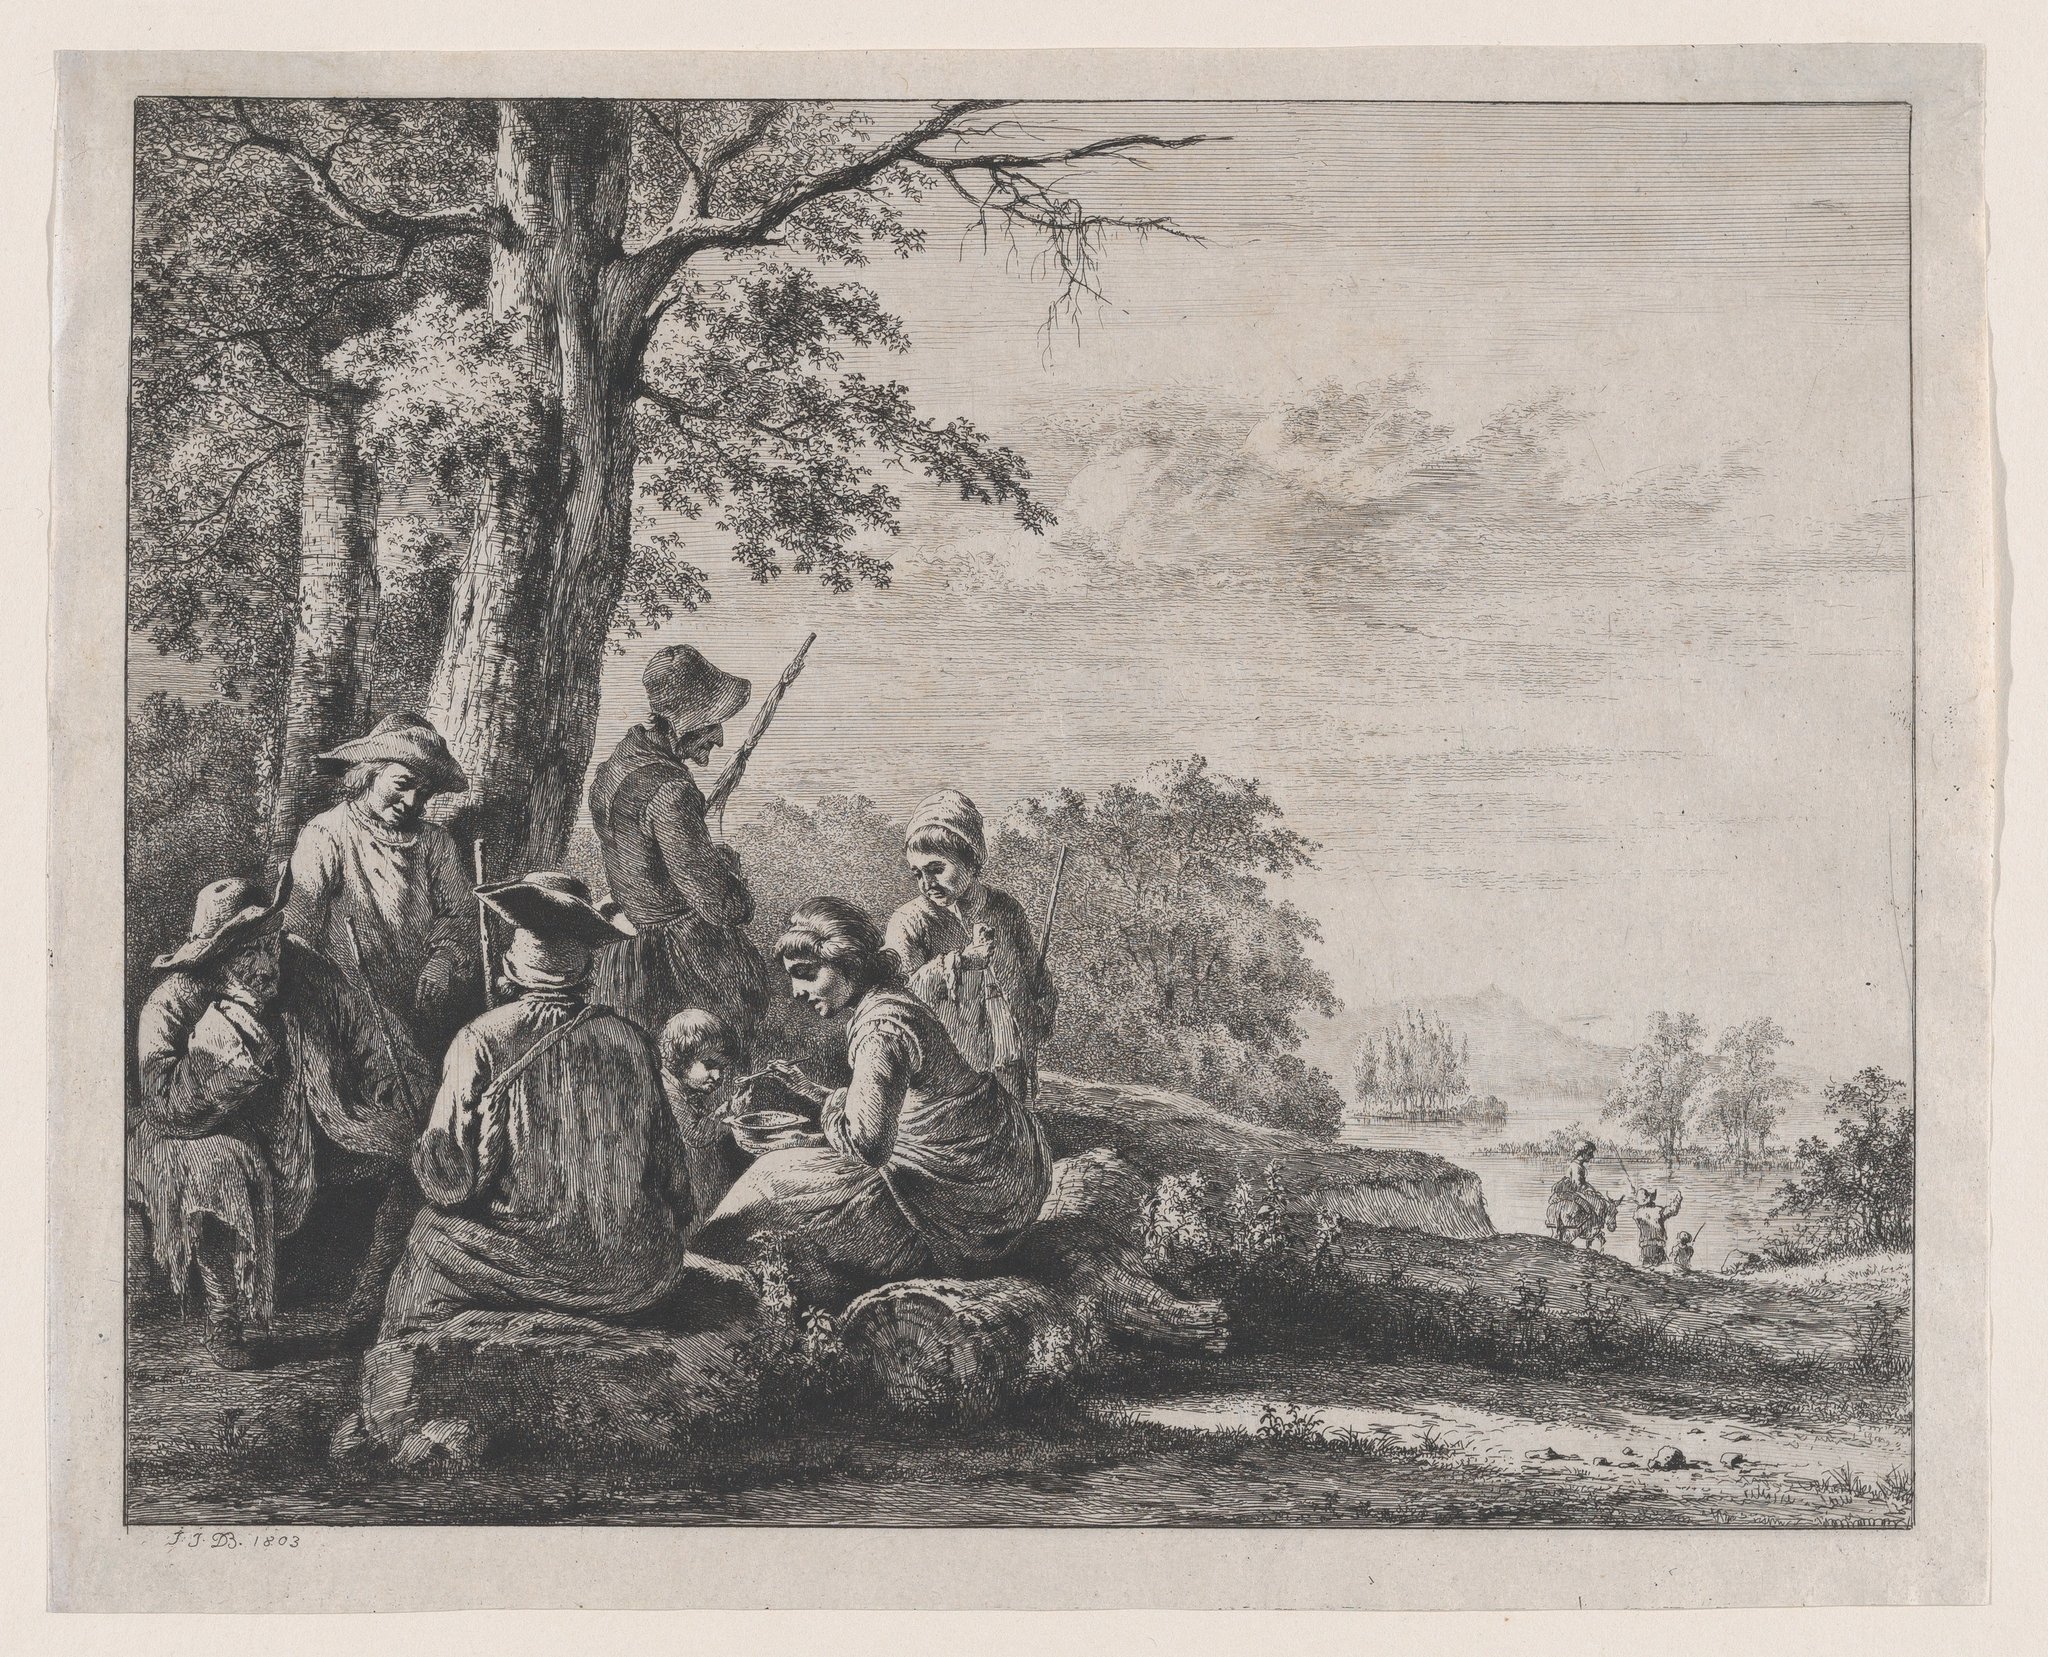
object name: print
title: Peasants Resting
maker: jean jacques de boissieu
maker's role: artist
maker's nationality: french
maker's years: 1736-1810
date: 1803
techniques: drypoint, etching, roulette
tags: children,men,women,landscapes